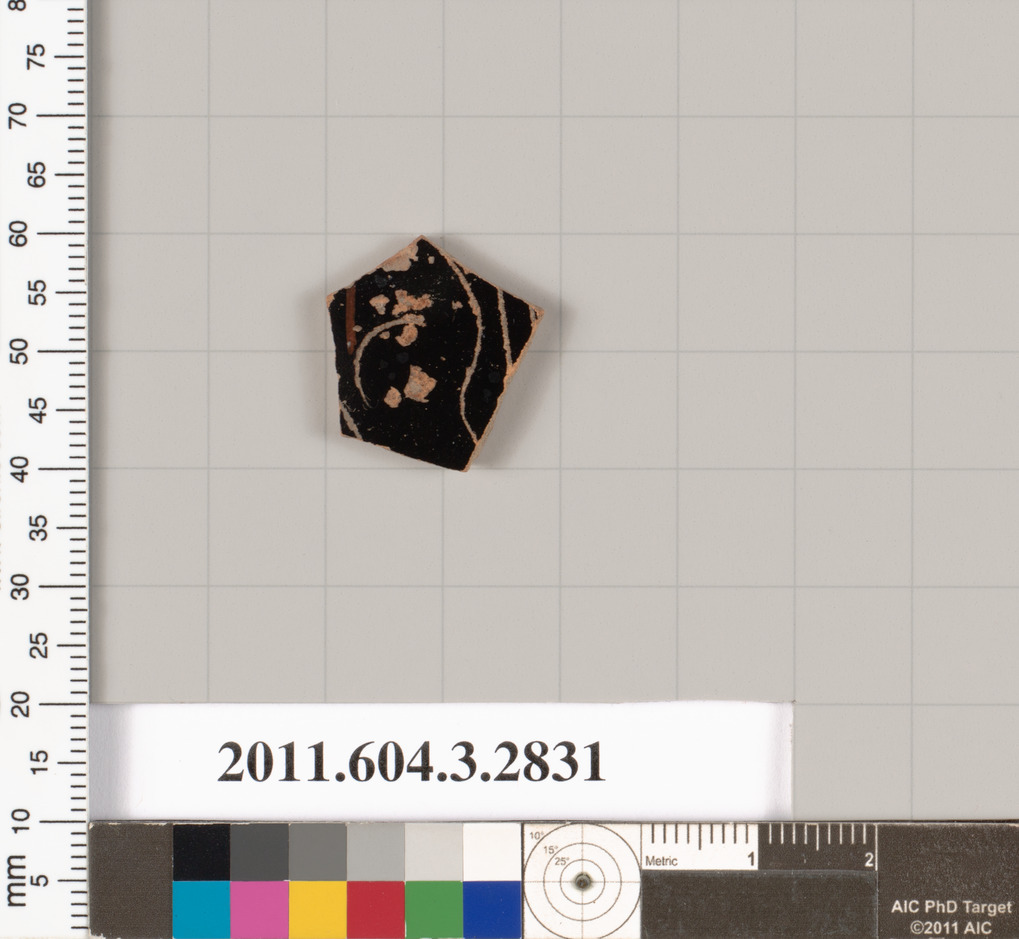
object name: oinochoe or olpe fragment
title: Terracotta fragment of an oinochoe (jug) or an olpe (jug)?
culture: greek, attic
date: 510-500 BCE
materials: terracotta